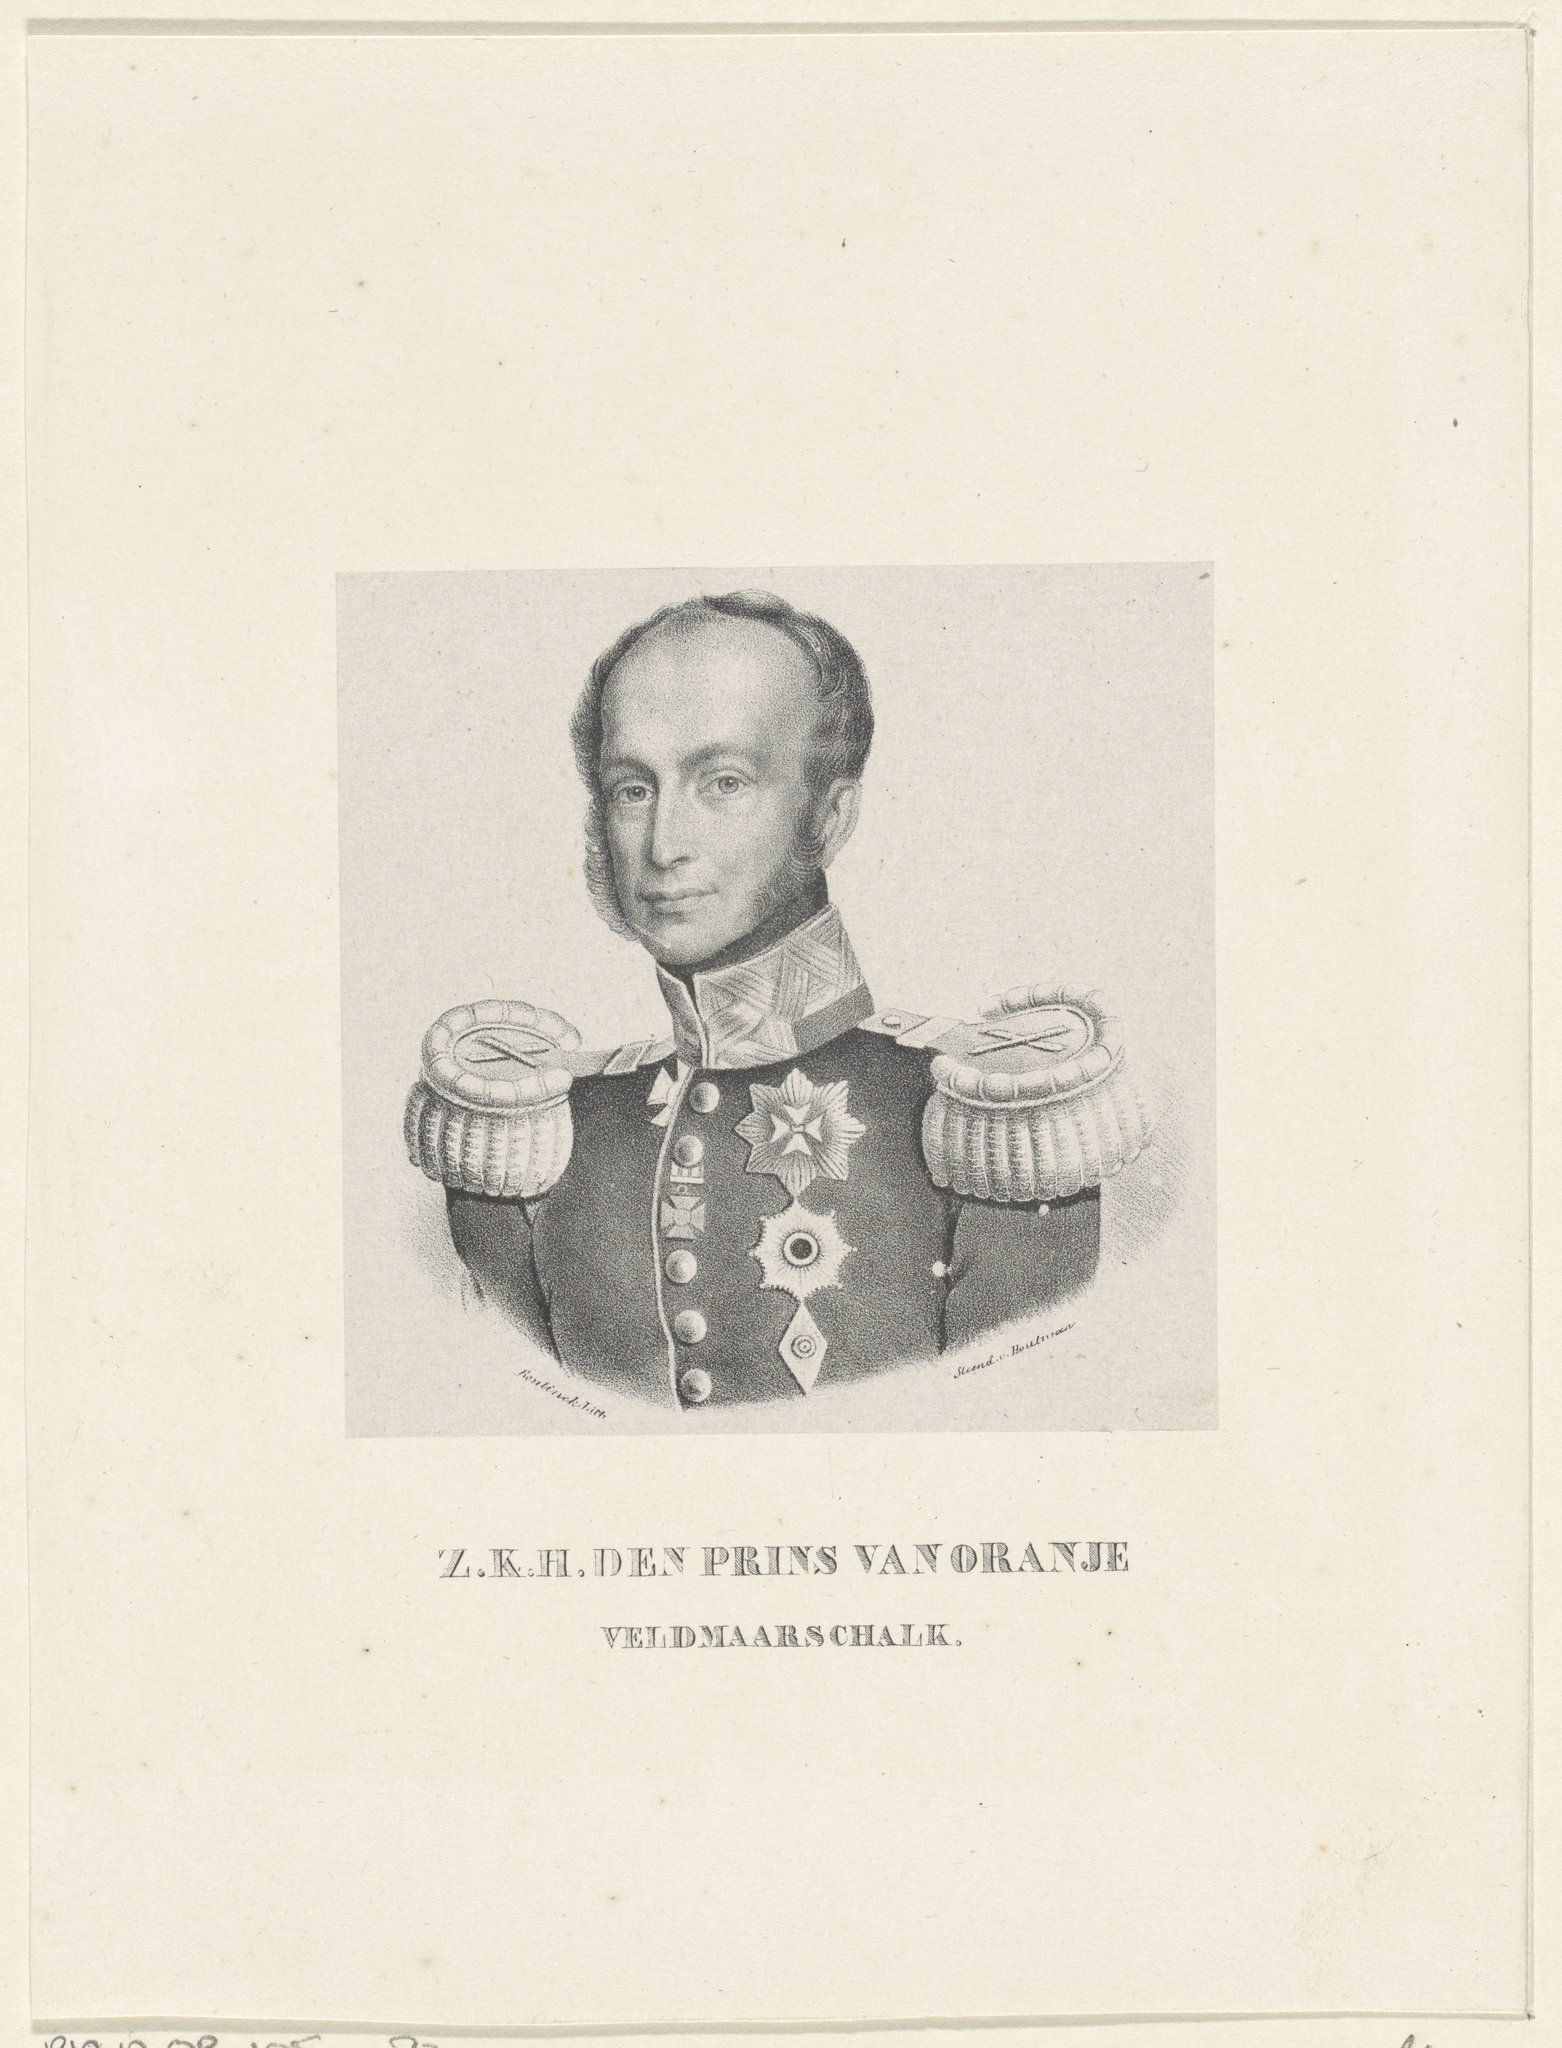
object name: print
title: Portret van Willem II, koning der Nederlanden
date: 1830-1845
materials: paper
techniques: lithograph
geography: utrecht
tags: the hague, william ii of the netherlands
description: De hier vermelde titel verwijst naar de hoogst verkregen titel van de geportretteerde, niet per se naar de titel die de geportretteerde op deze voorstelling draagt.